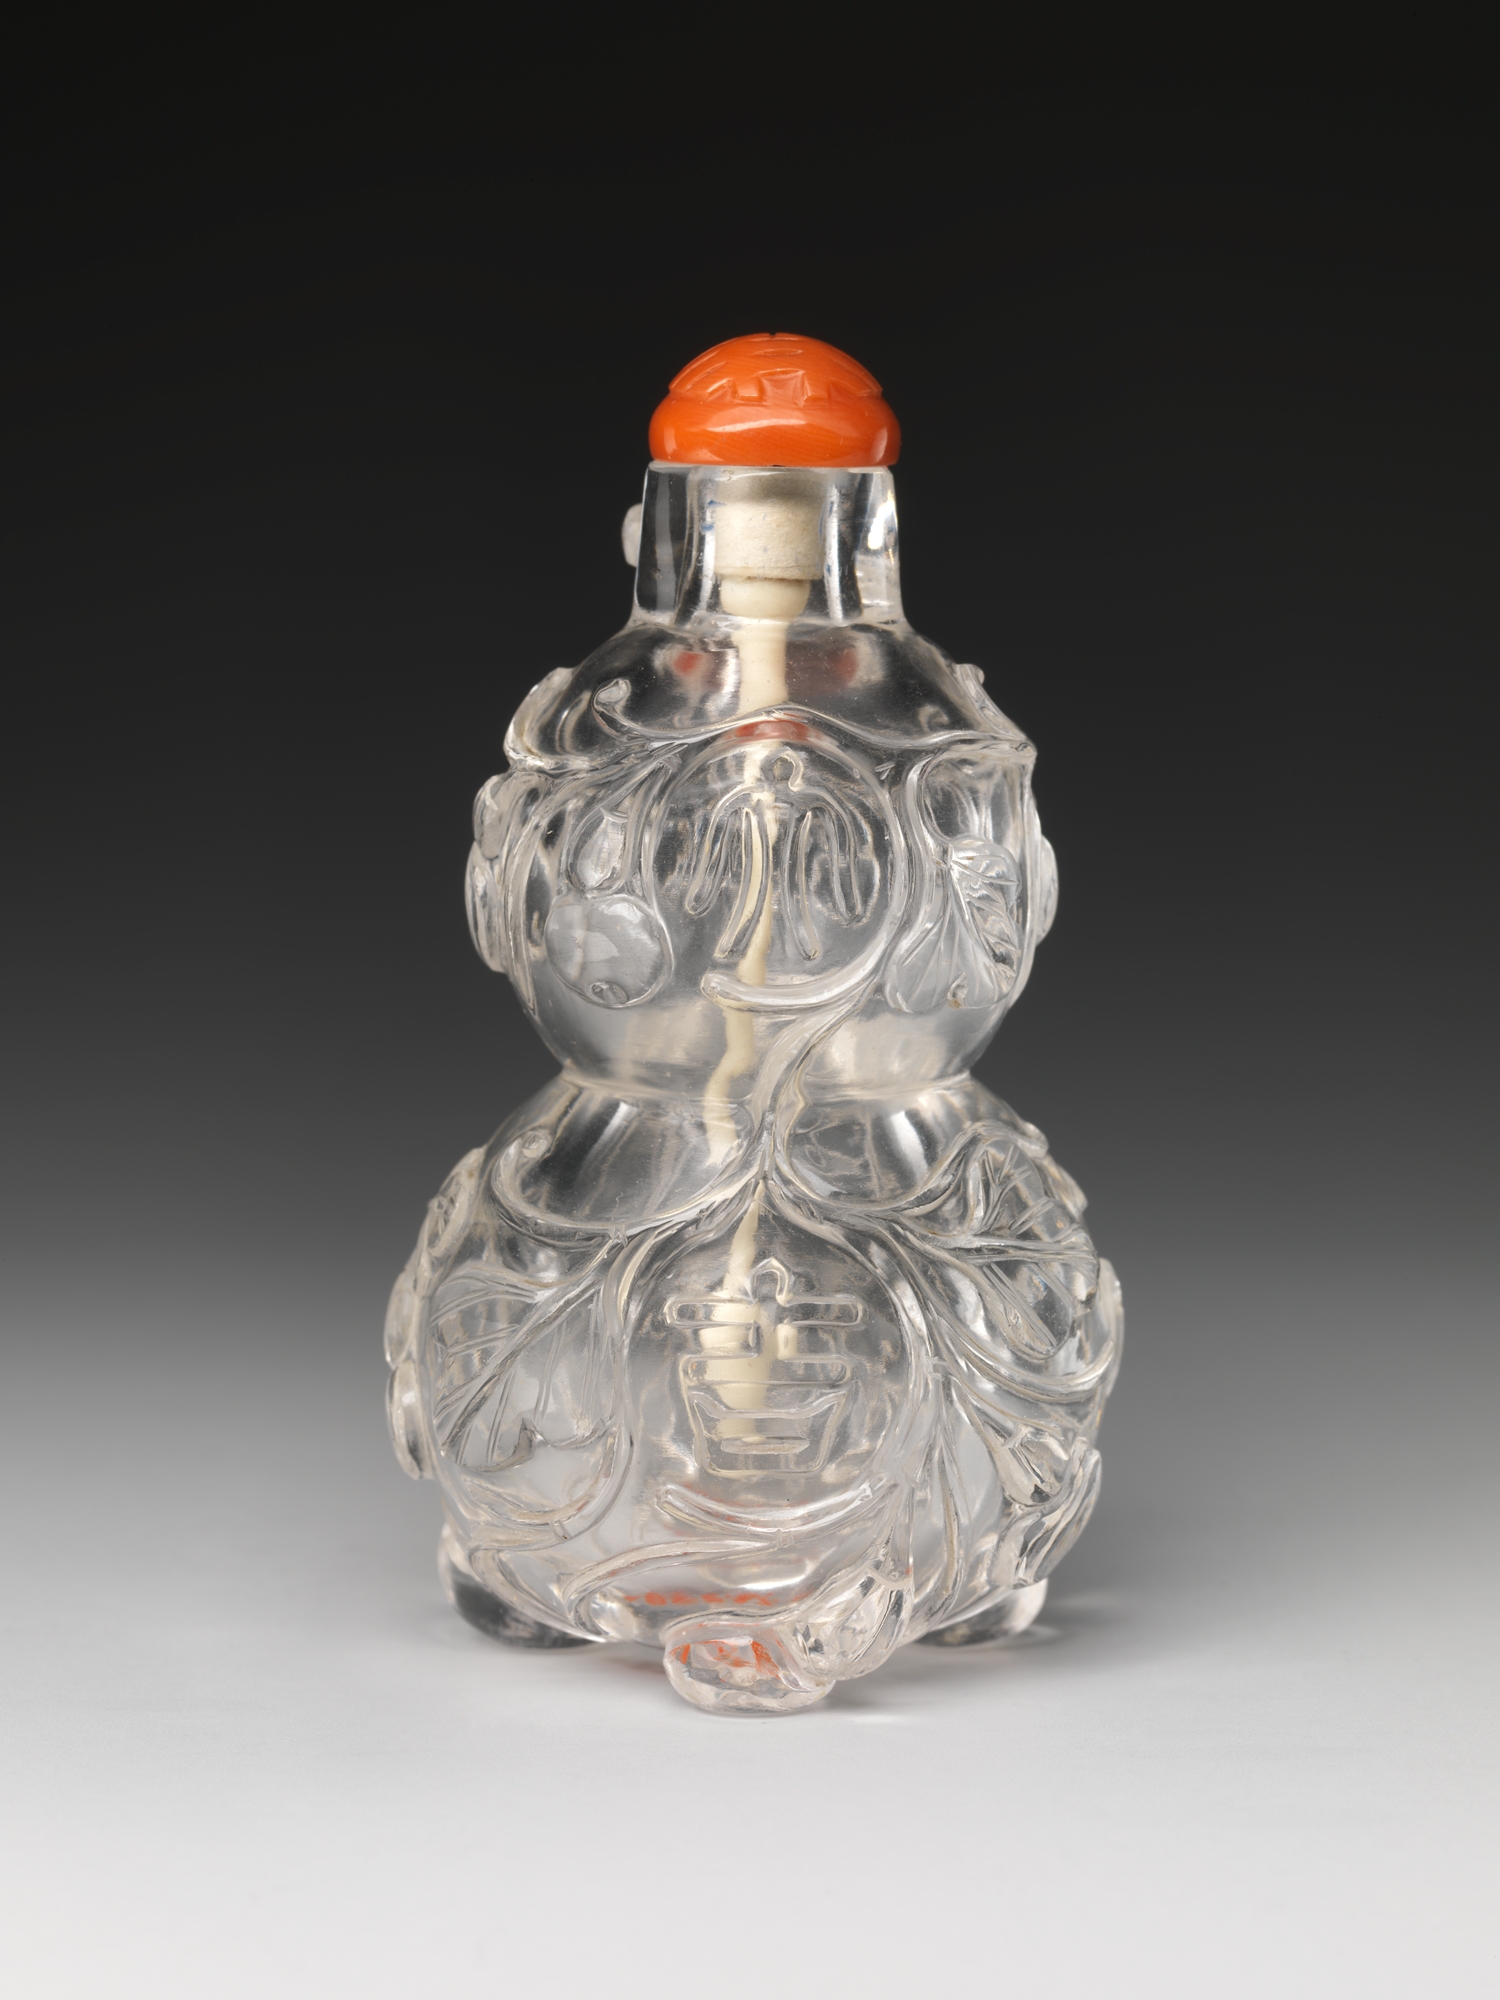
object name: snuff bottle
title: Snuff Bottle in the Shape of a Gourd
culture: chinese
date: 1767-1833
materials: coral, quartz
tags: gourds